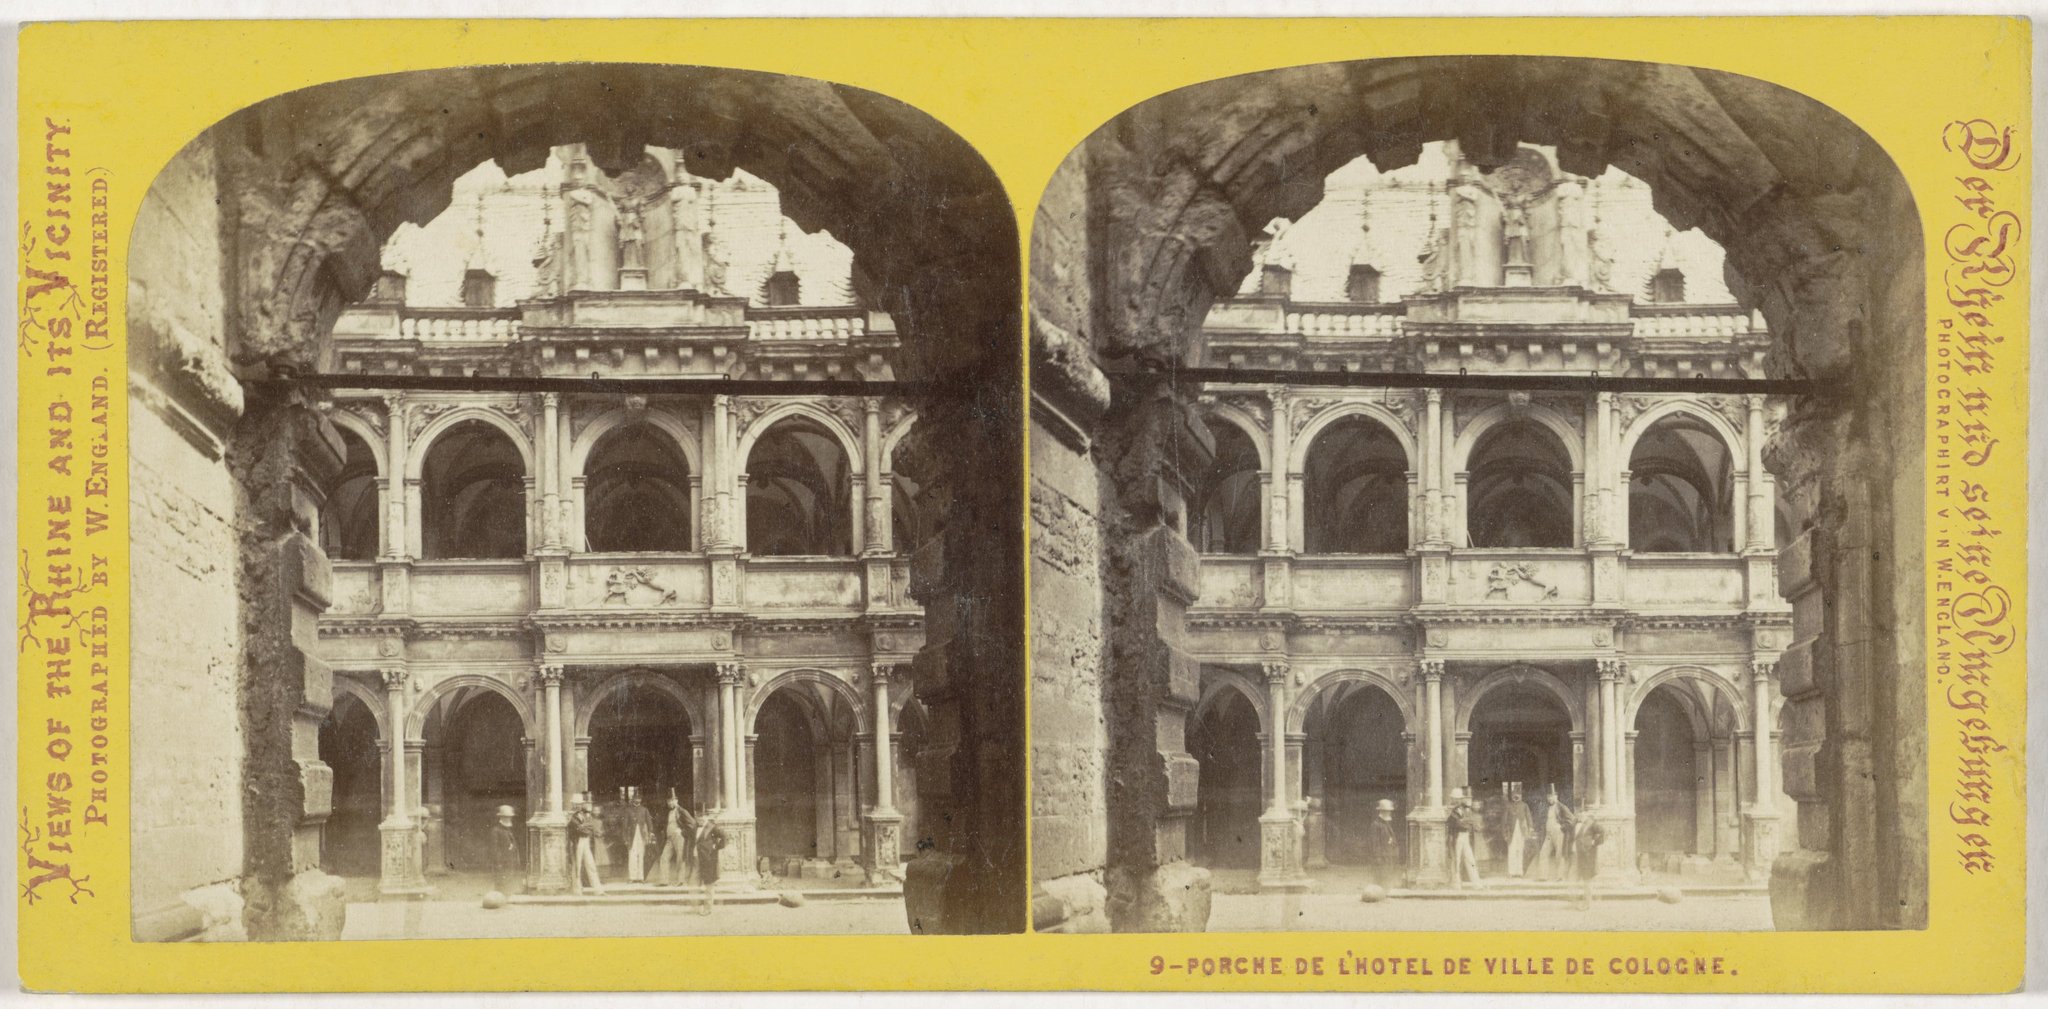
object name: stereograph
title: Views of the Rhine and its Vicinity / Der Rhein und seine Umgebungen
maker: william england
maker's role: fotograaf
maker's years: 1816-1896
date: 1867-1868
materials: cardboard, paper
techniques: albumen print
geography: cologne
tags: townhall, loggia, verandah, porch, cologne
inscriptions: inscription: ‘(Registered)’, number: ‘9’